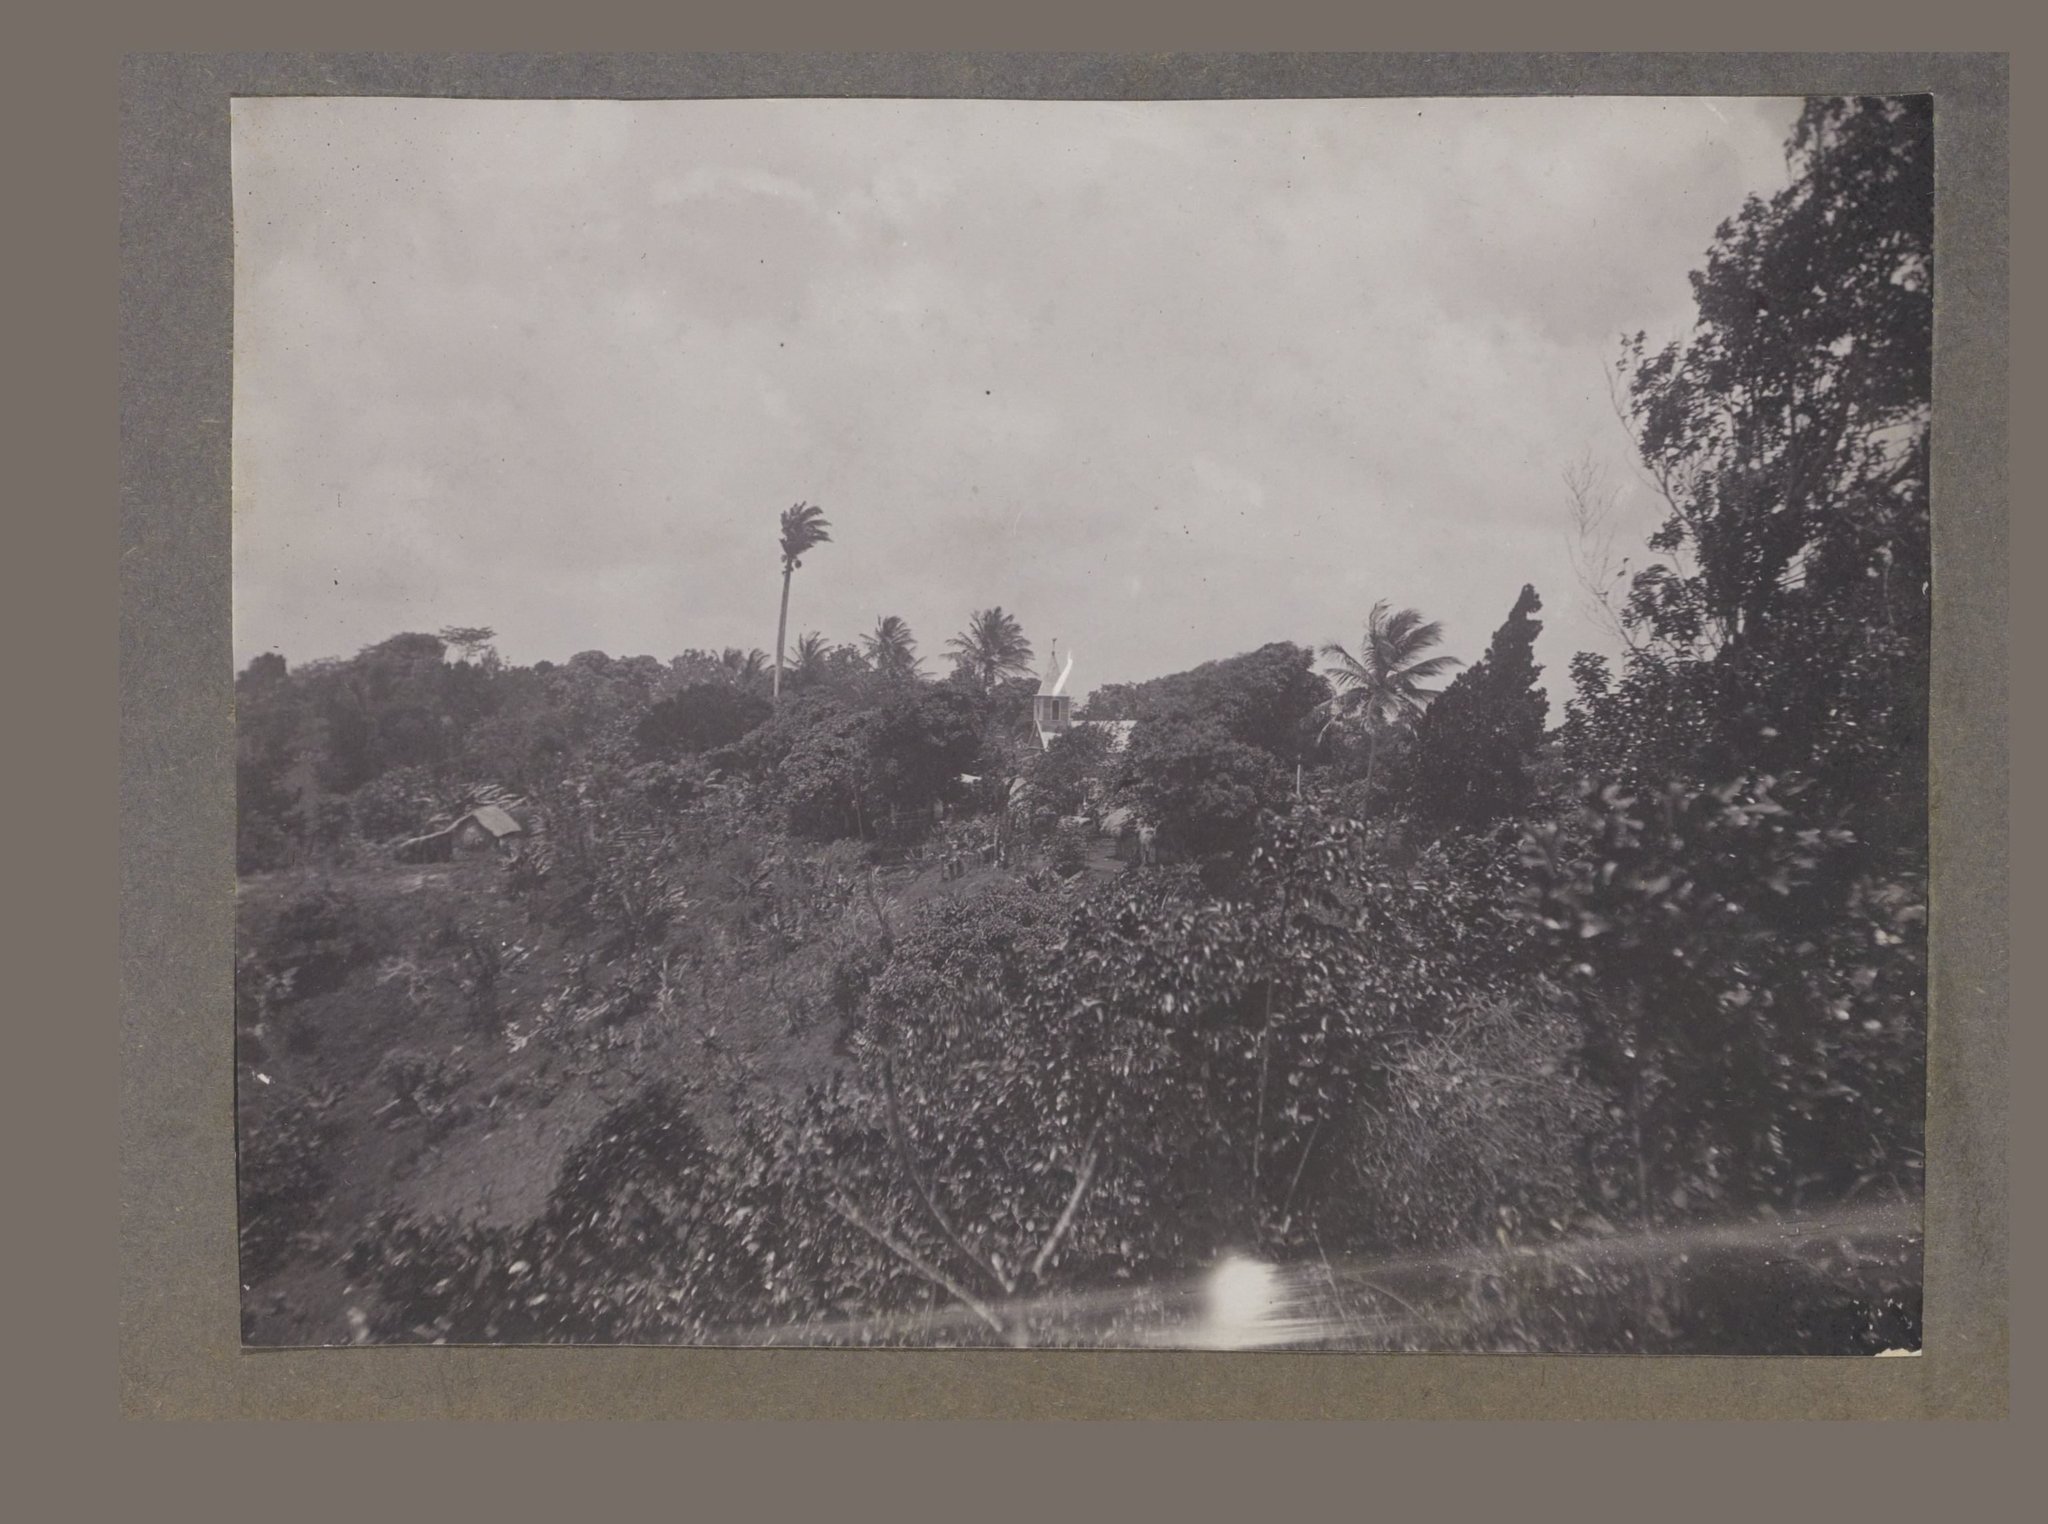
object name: photograph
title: Kerk tussen bomen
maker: Anonymous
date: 1912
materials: photographic support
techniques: photography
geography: suriname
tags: suriname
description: Kerk in het bos. Onderdeel van het fotoalbum over het leven van de familie Gonggrijp in Suriname rond 1912.